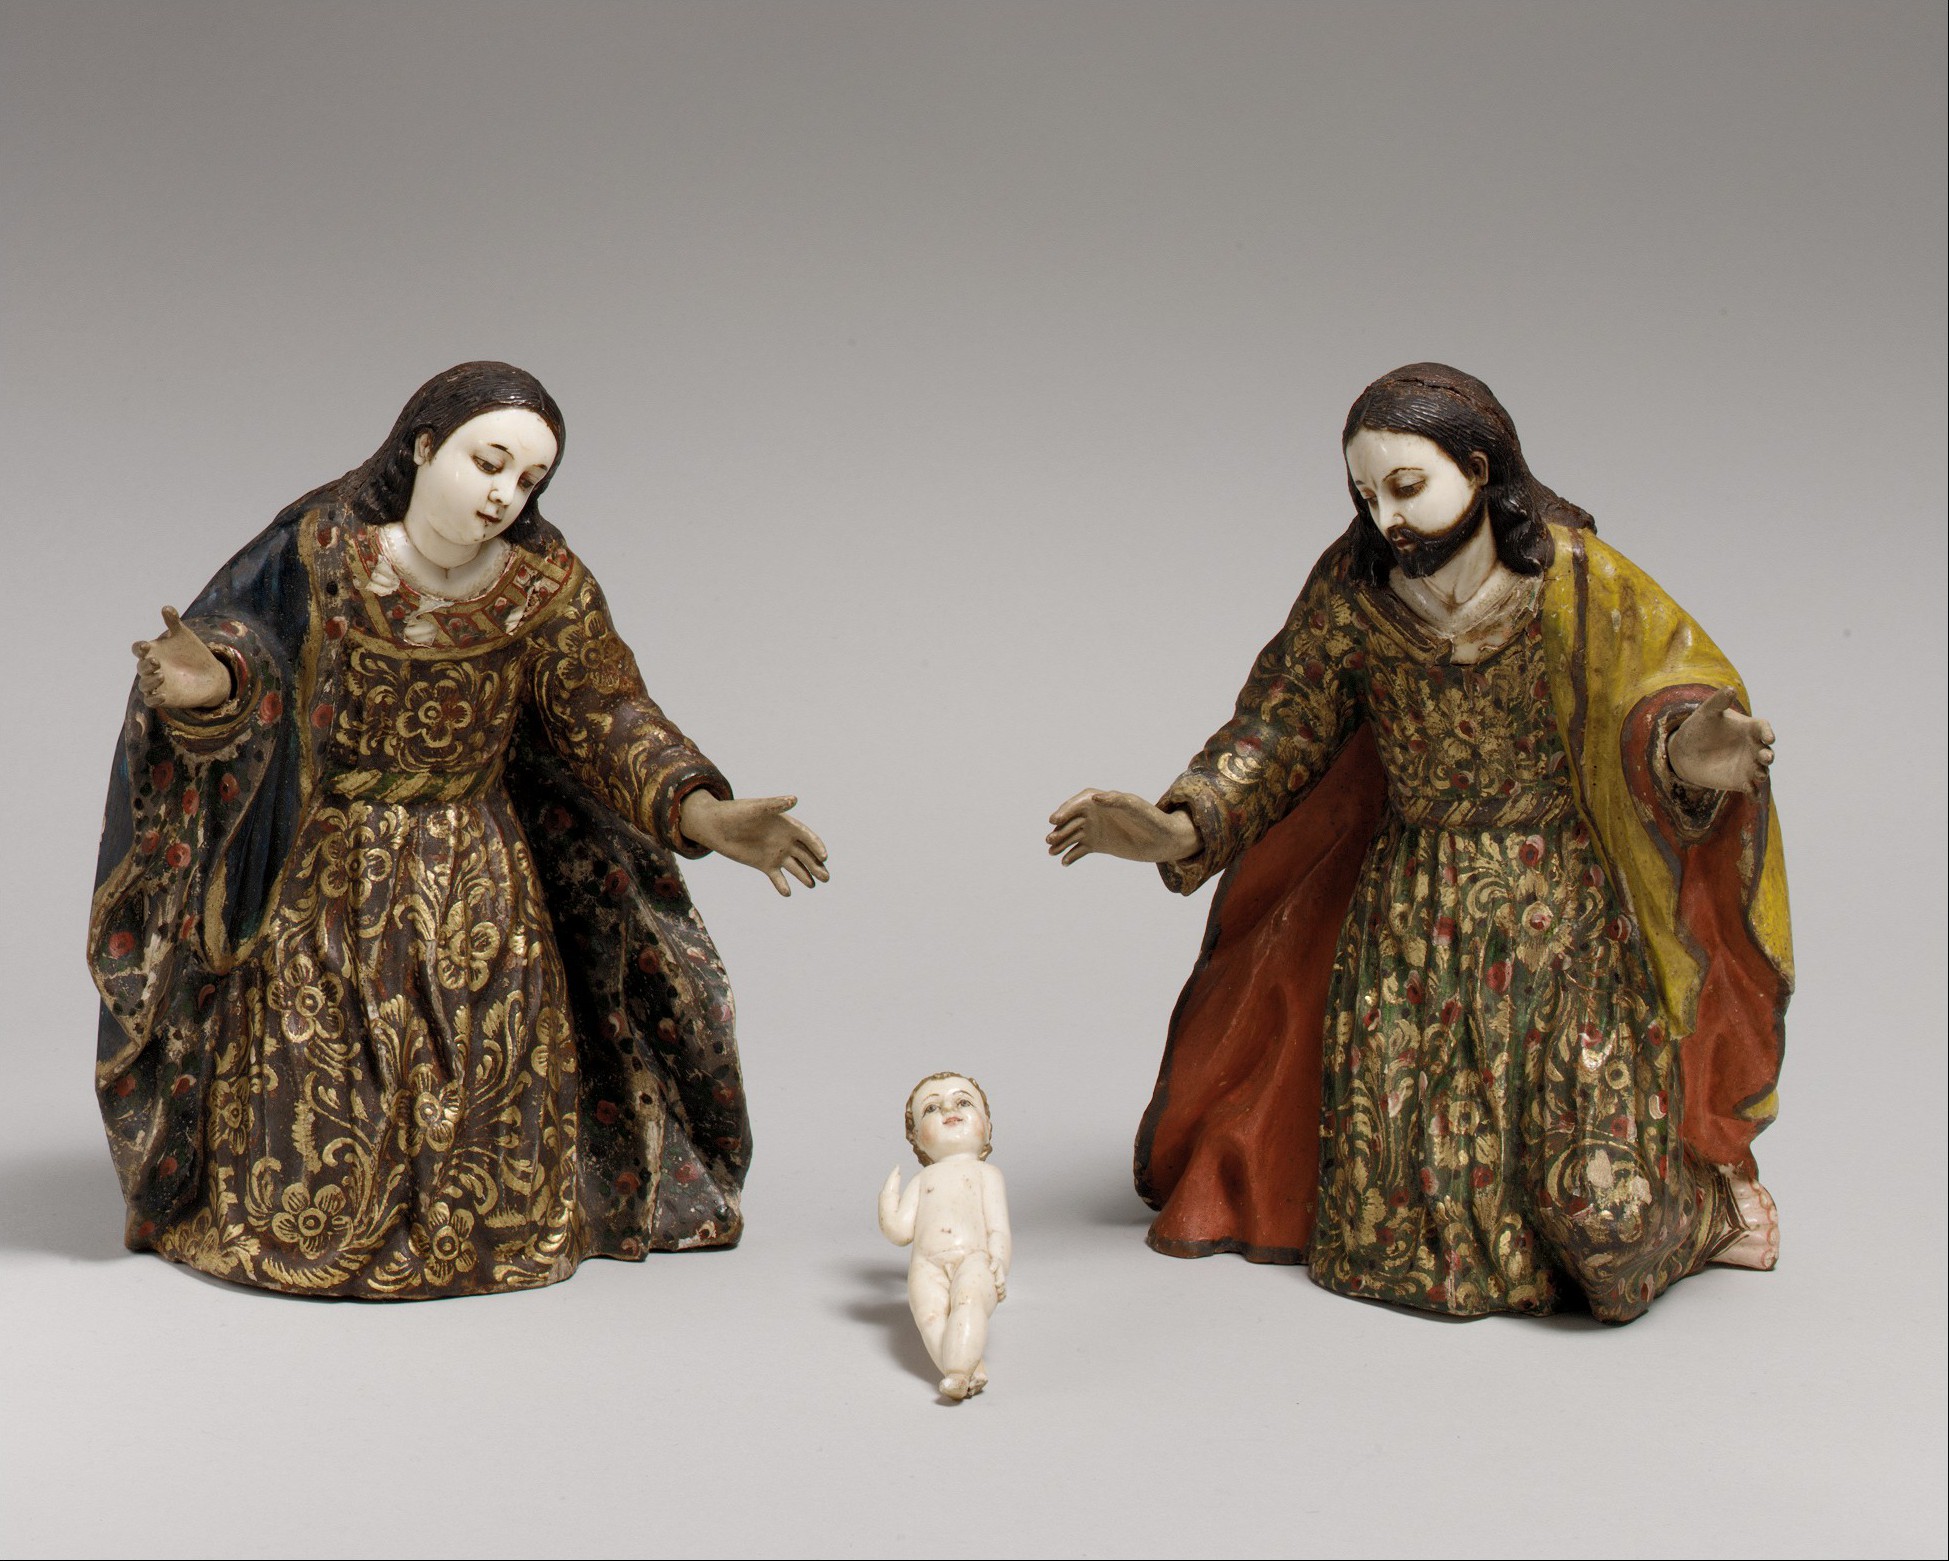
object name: statuette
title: Mary (from a nativity)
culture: ecuadorian or philippine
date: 1701-1800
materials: ivory, wood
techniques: gilding, polychrome, polychromy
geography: philippines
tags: men,christ,virgin mary